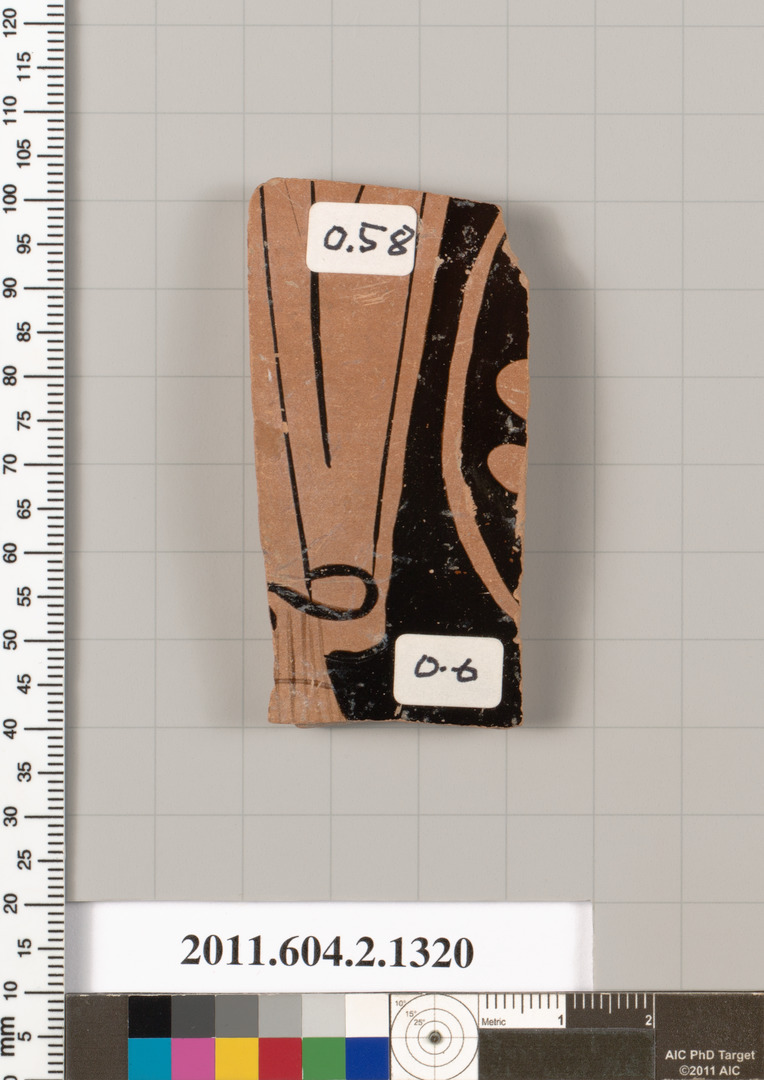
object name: skyphos fragment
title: Terracotta fragment of a skyphos (deep drinking cup)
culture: greek, attic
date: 434-368 BCE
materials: terracotta